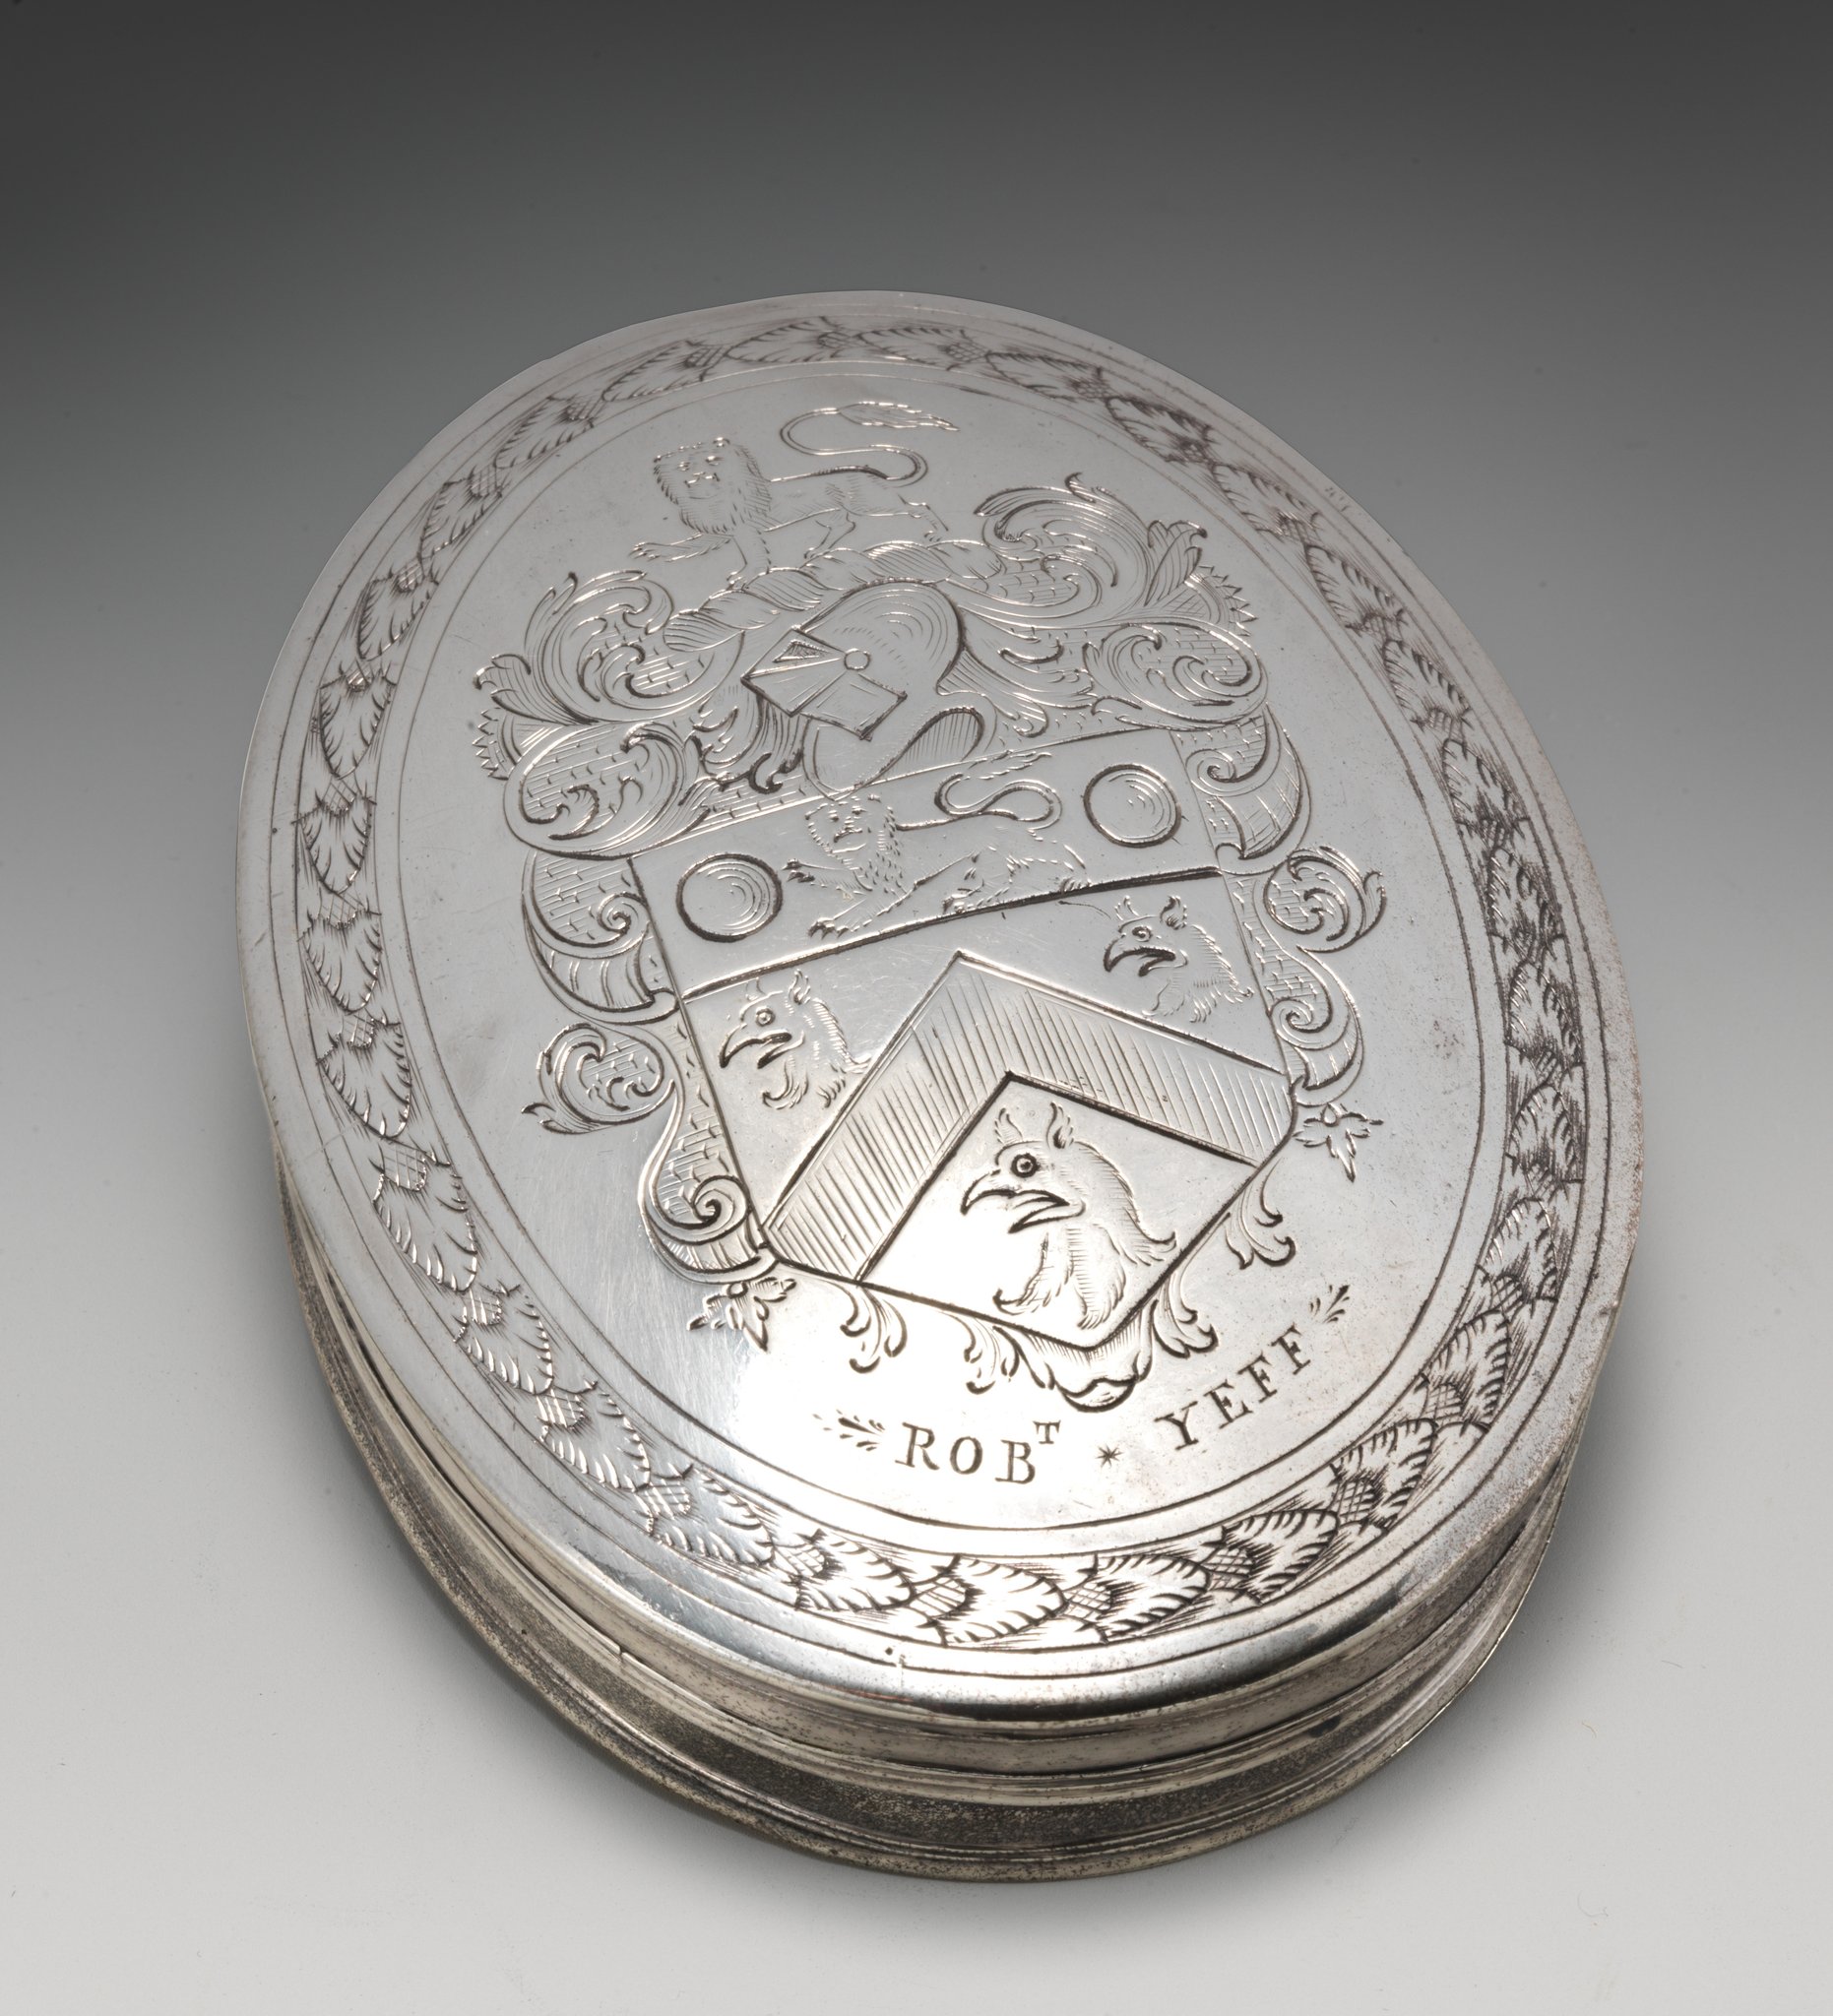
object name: tobacco box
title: Tobacco box inscribed with the name Robert Yeff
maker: thomas hartwell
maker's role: maker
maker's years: 1702-1703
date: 1701-1733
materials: silver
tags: coat of arms